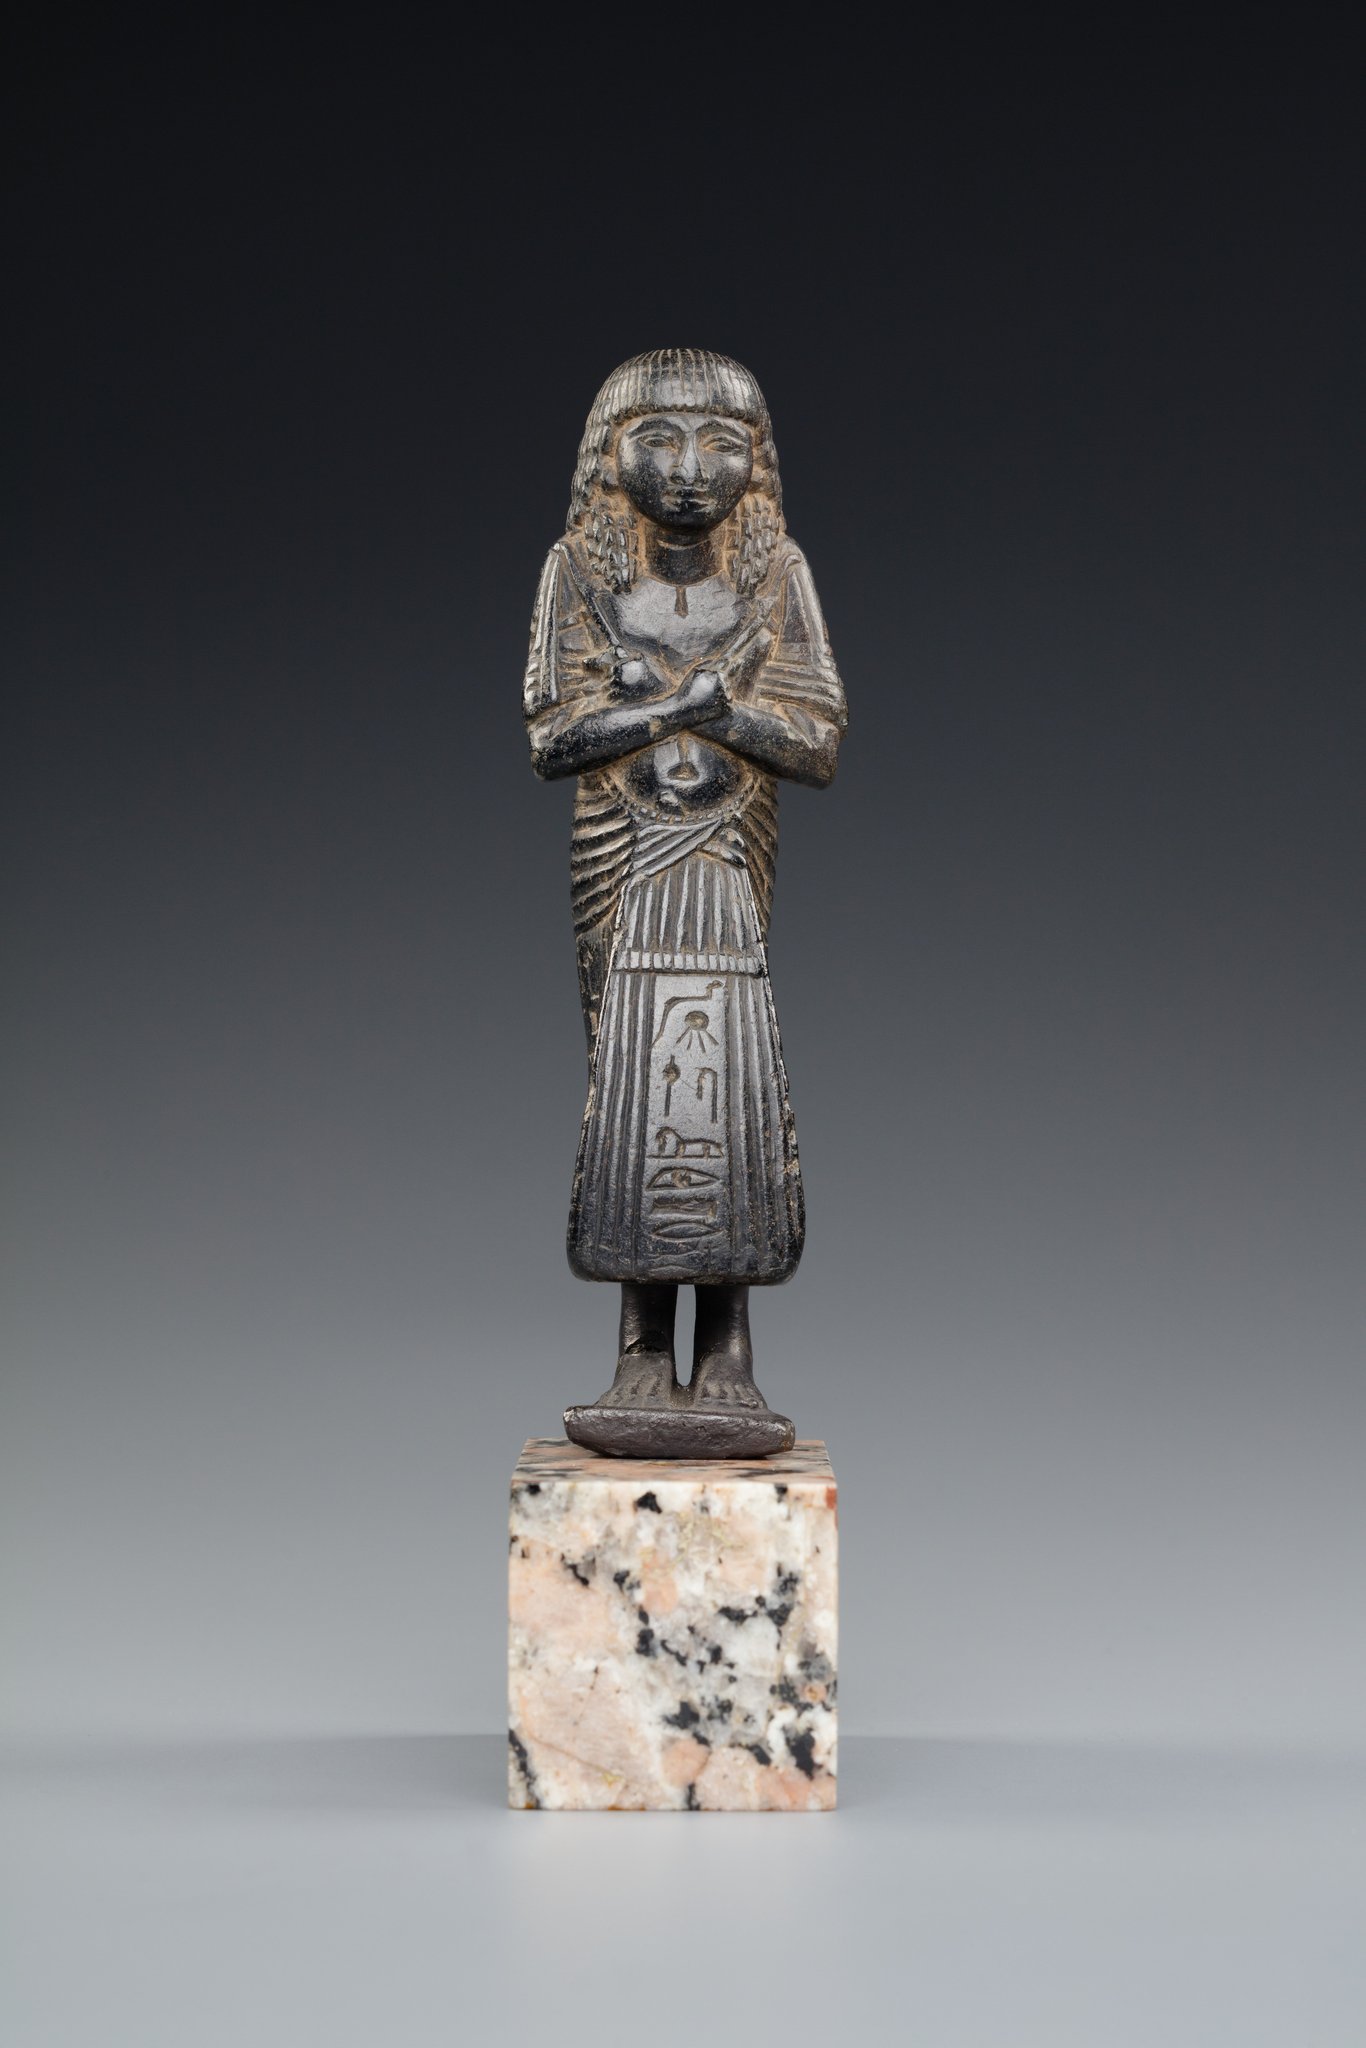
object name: shabti of sherinefer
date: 1295-1186 BCE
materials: stone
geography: egypt